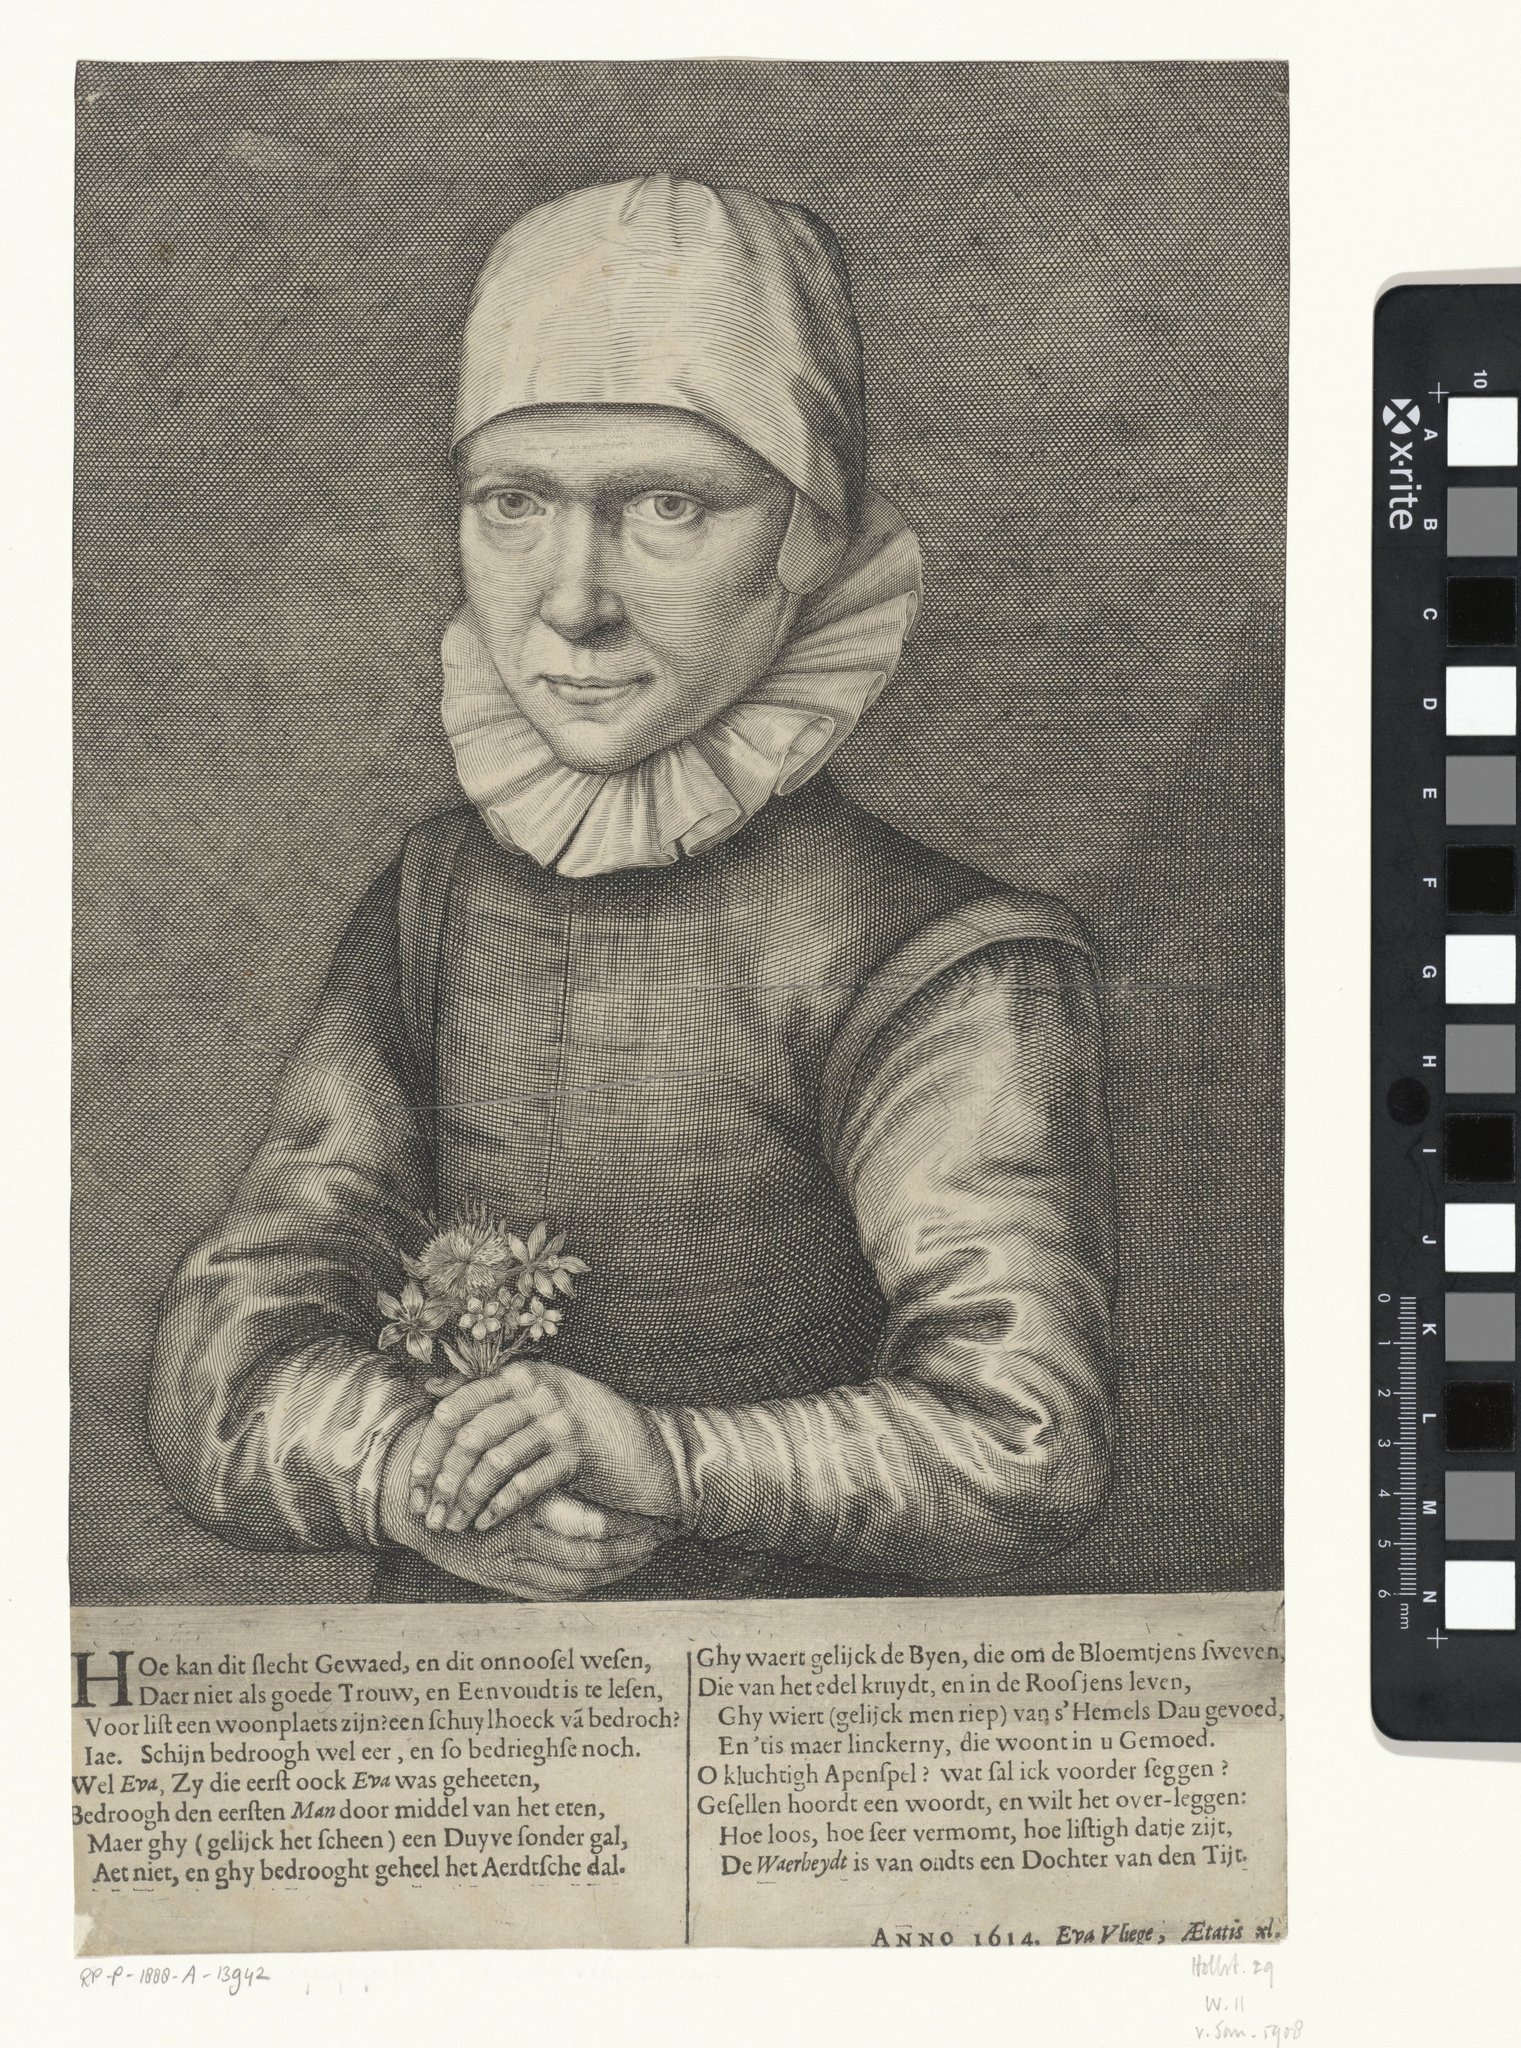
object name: print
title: Portret van Eva Vliegen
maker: andries jacobsz. stock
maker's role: print maker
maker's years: 1572-1648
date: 1614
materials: paper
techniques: engraving, letterpress printing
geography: the hague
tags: cut flowers; nosegay, bunch of flowers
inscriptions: collector's mark: Lugt 2228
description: Portret van Eva Vliegen op 40-jarige leeftijd met een bosje bloemen in haar handen. Onderaan in de marge een tekst in het Nederlands over haar leugenachtigheid. Eva Vliegen, bijgenaamd Besje Meurs, stond bekend om het feit dat zij niet at. Er werd gezegd dat ze leefde van bloemengeur. Veel mensen geloofden dit niet, waardoor ze bekend stond als leugenaar.